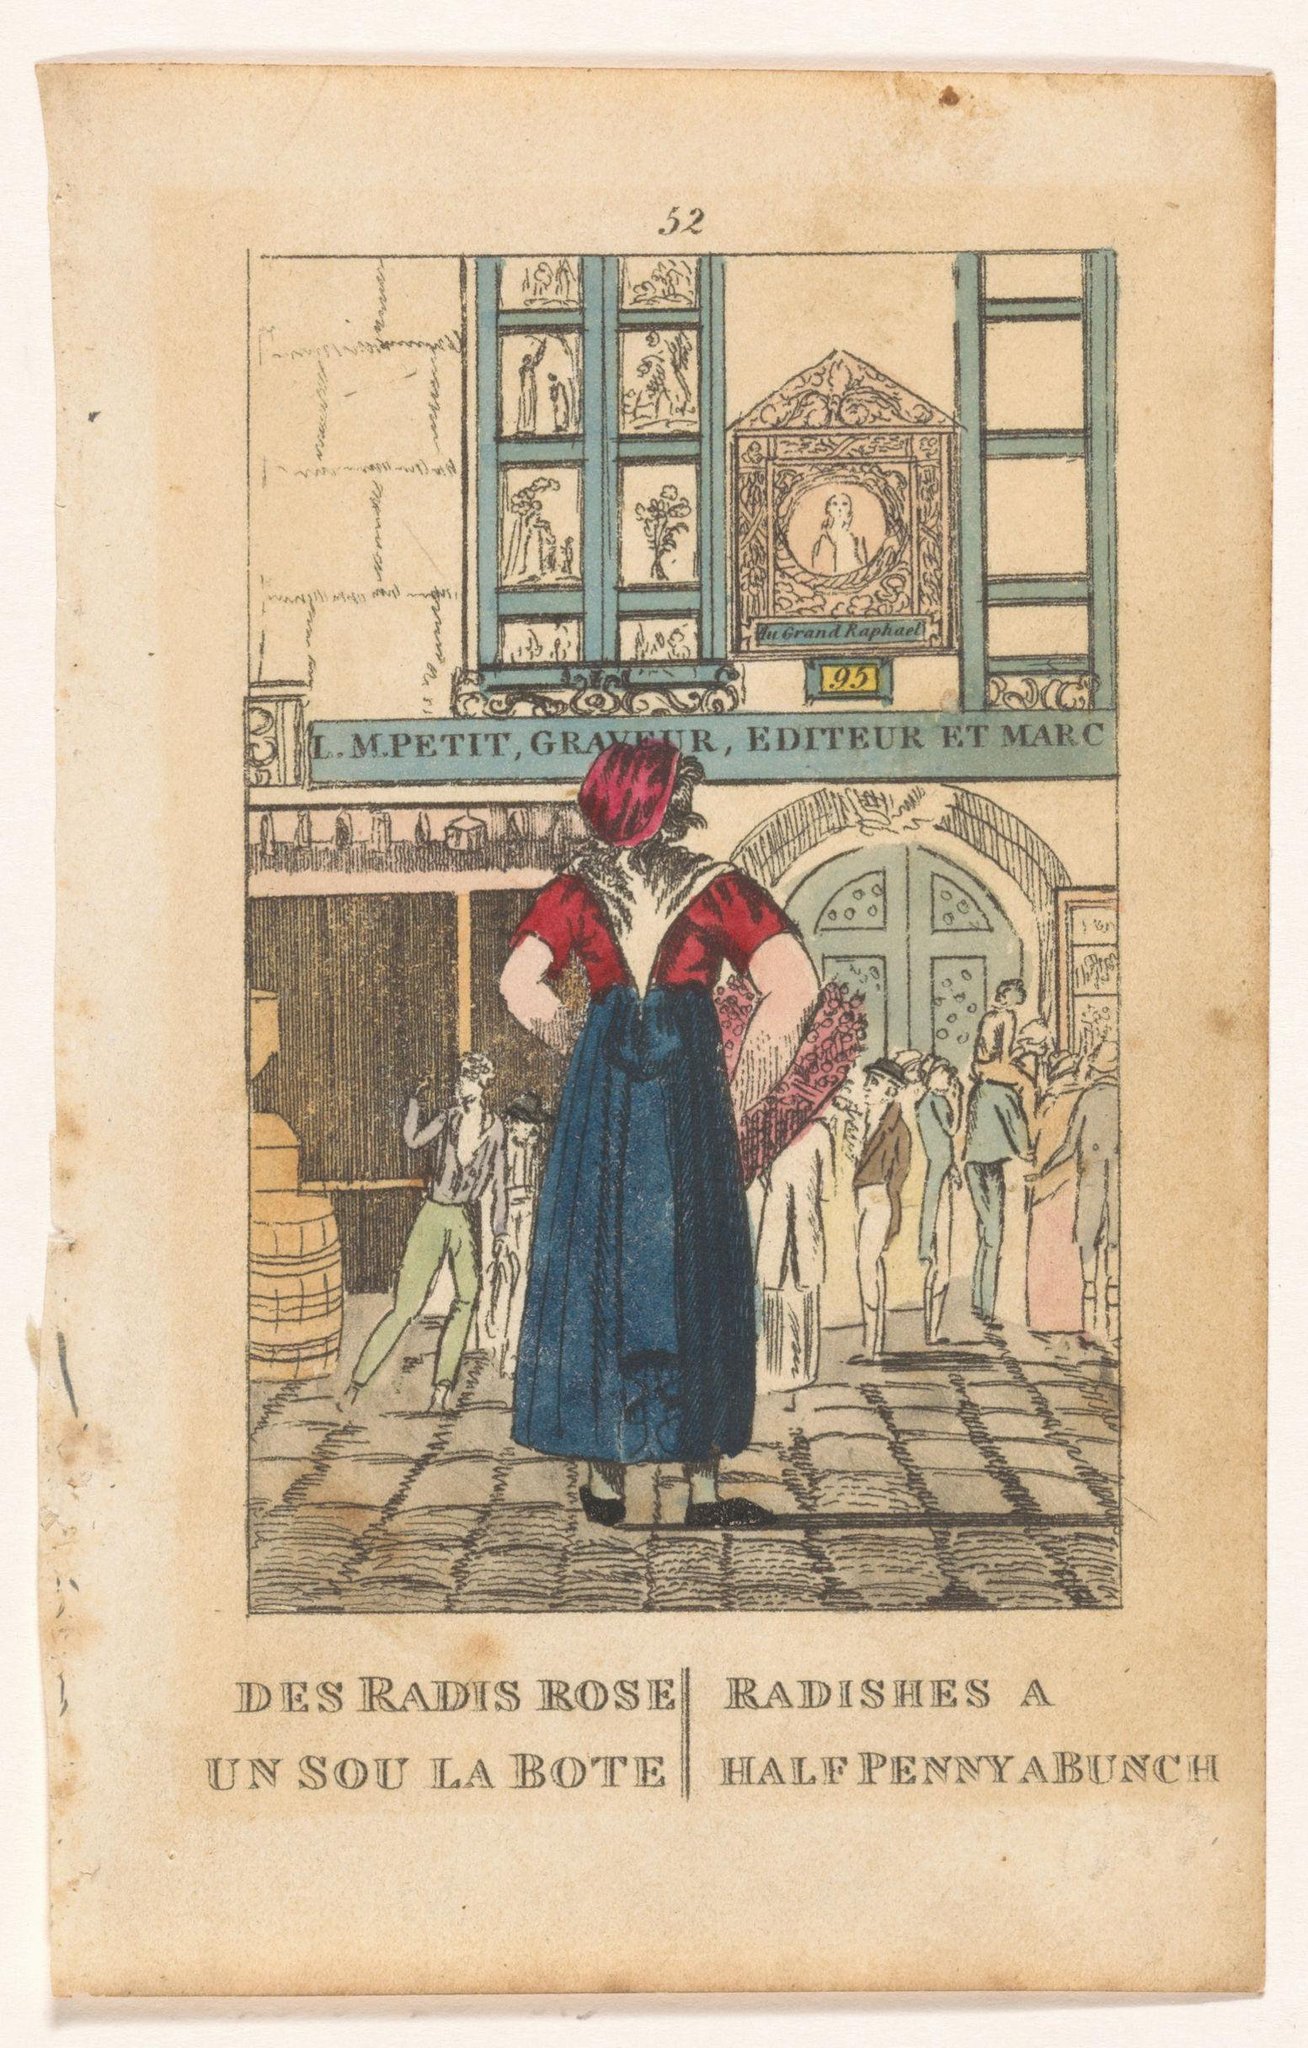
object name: print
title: Straatverkoopster voor de gevel van L.M. Petit te Parijs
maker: Anonymous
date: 1810-1850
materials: paper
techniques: etching, hand coloring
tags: street-trader, 'cris de paris', cries of london, etc. - bb - women engaged in trade and commerce, paris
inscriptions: collector's mark: Lugt 2228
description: Straatverkoopster met radijsjes op een plein voor de gevel van graveur en uitgever L.M. Petit te Parijs. De gevel is versierd en draagt de naam "Au Grand Raphael". Voor de deur van winkel staan enkele mensen te kijken naar ingelijste prenten.